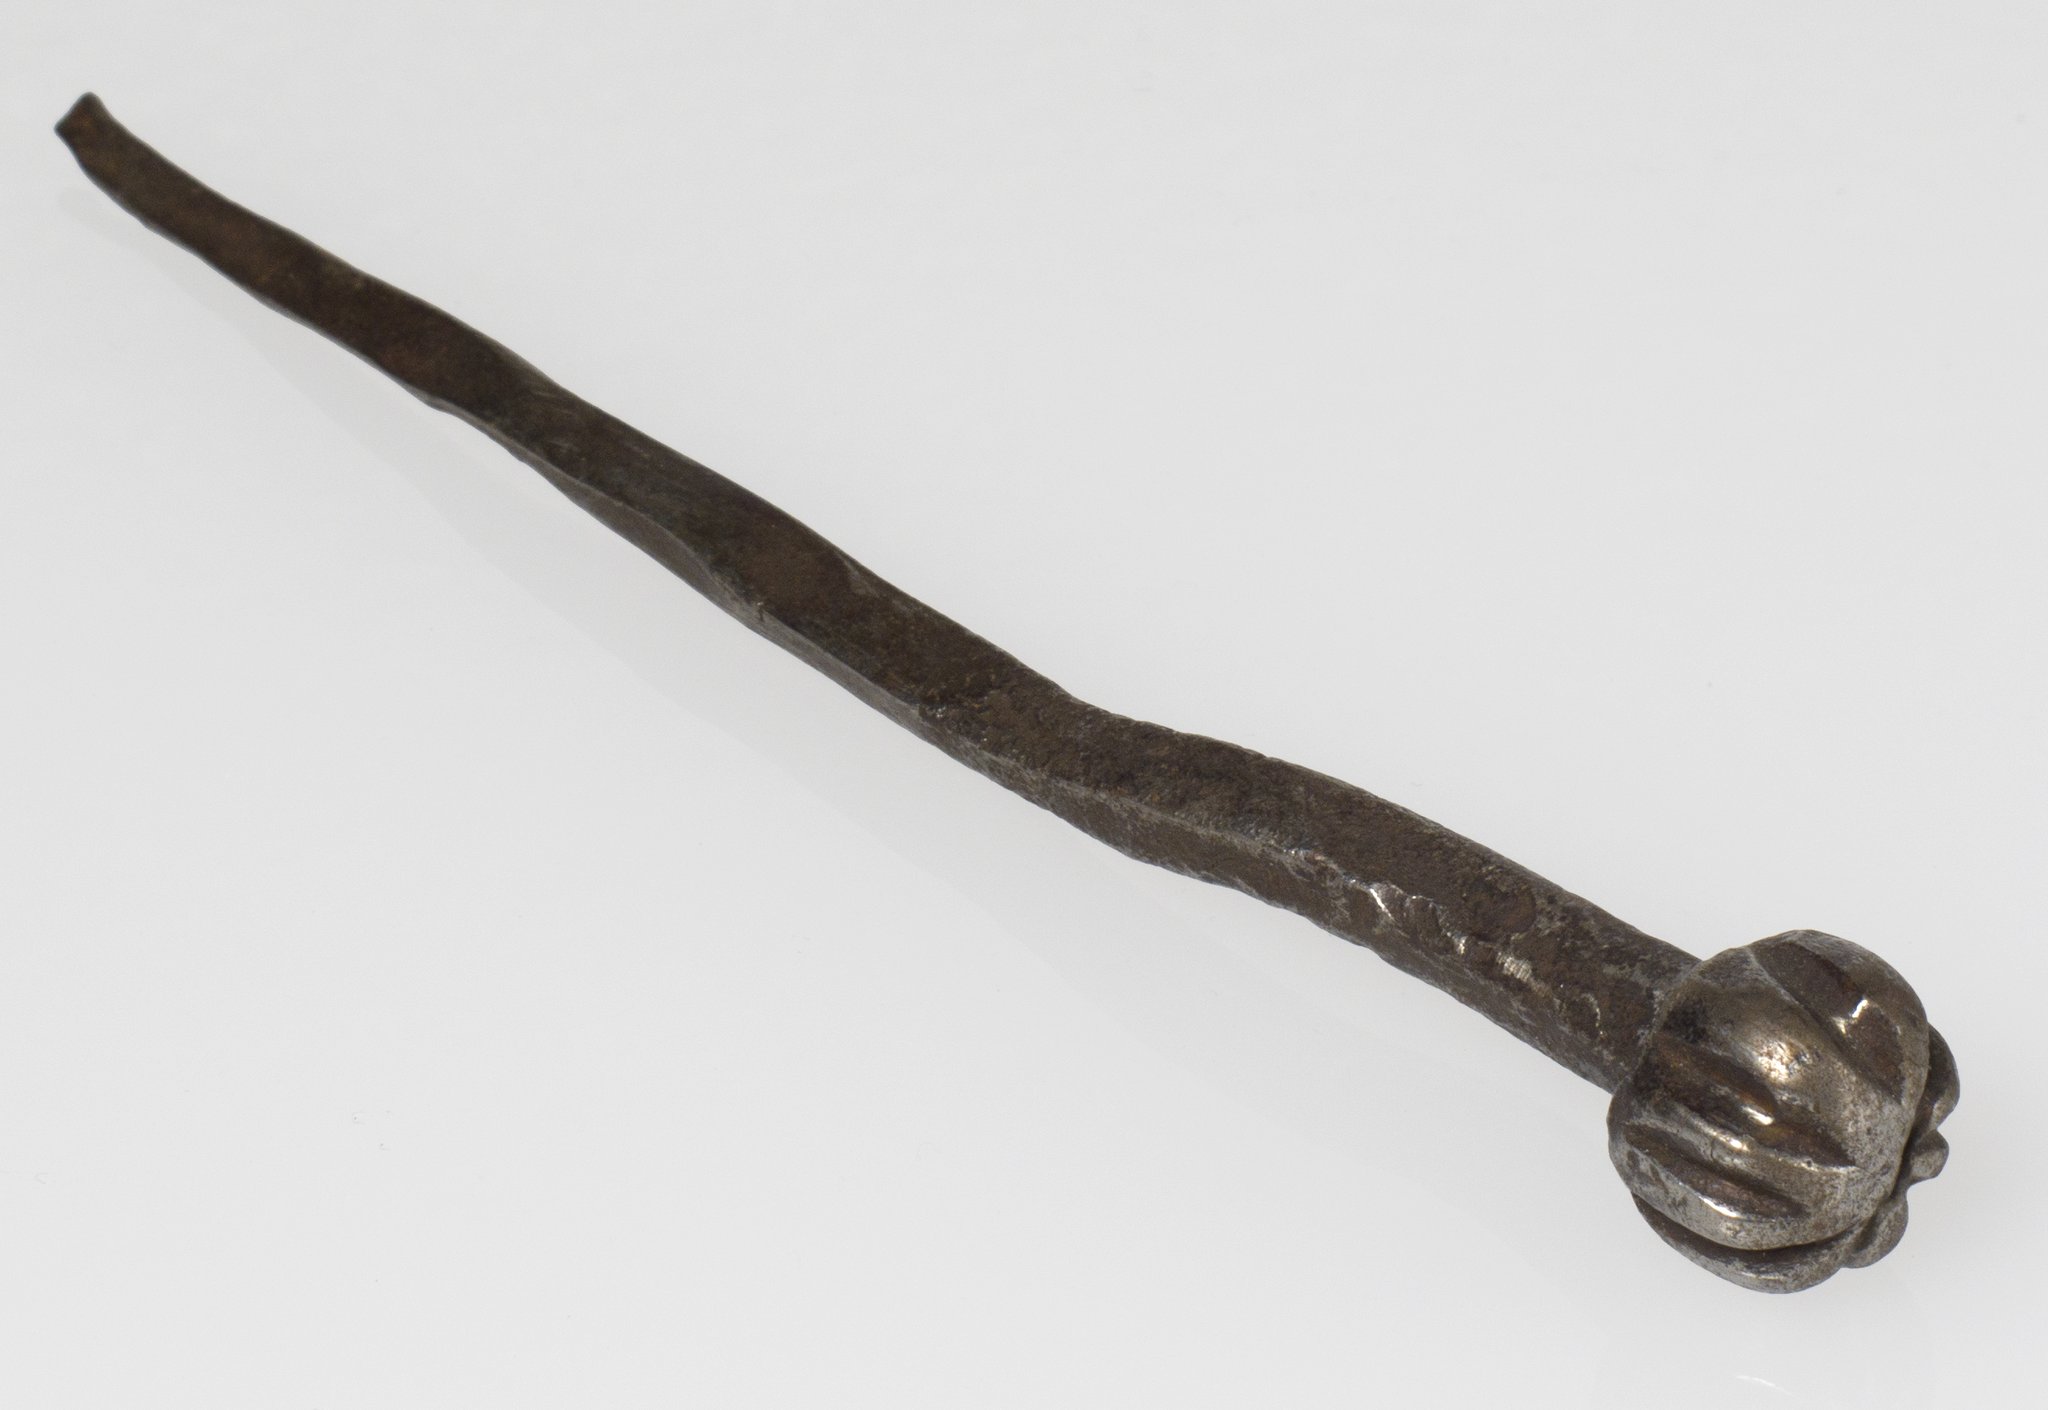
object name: nail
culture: european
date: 1401-1600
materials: iron